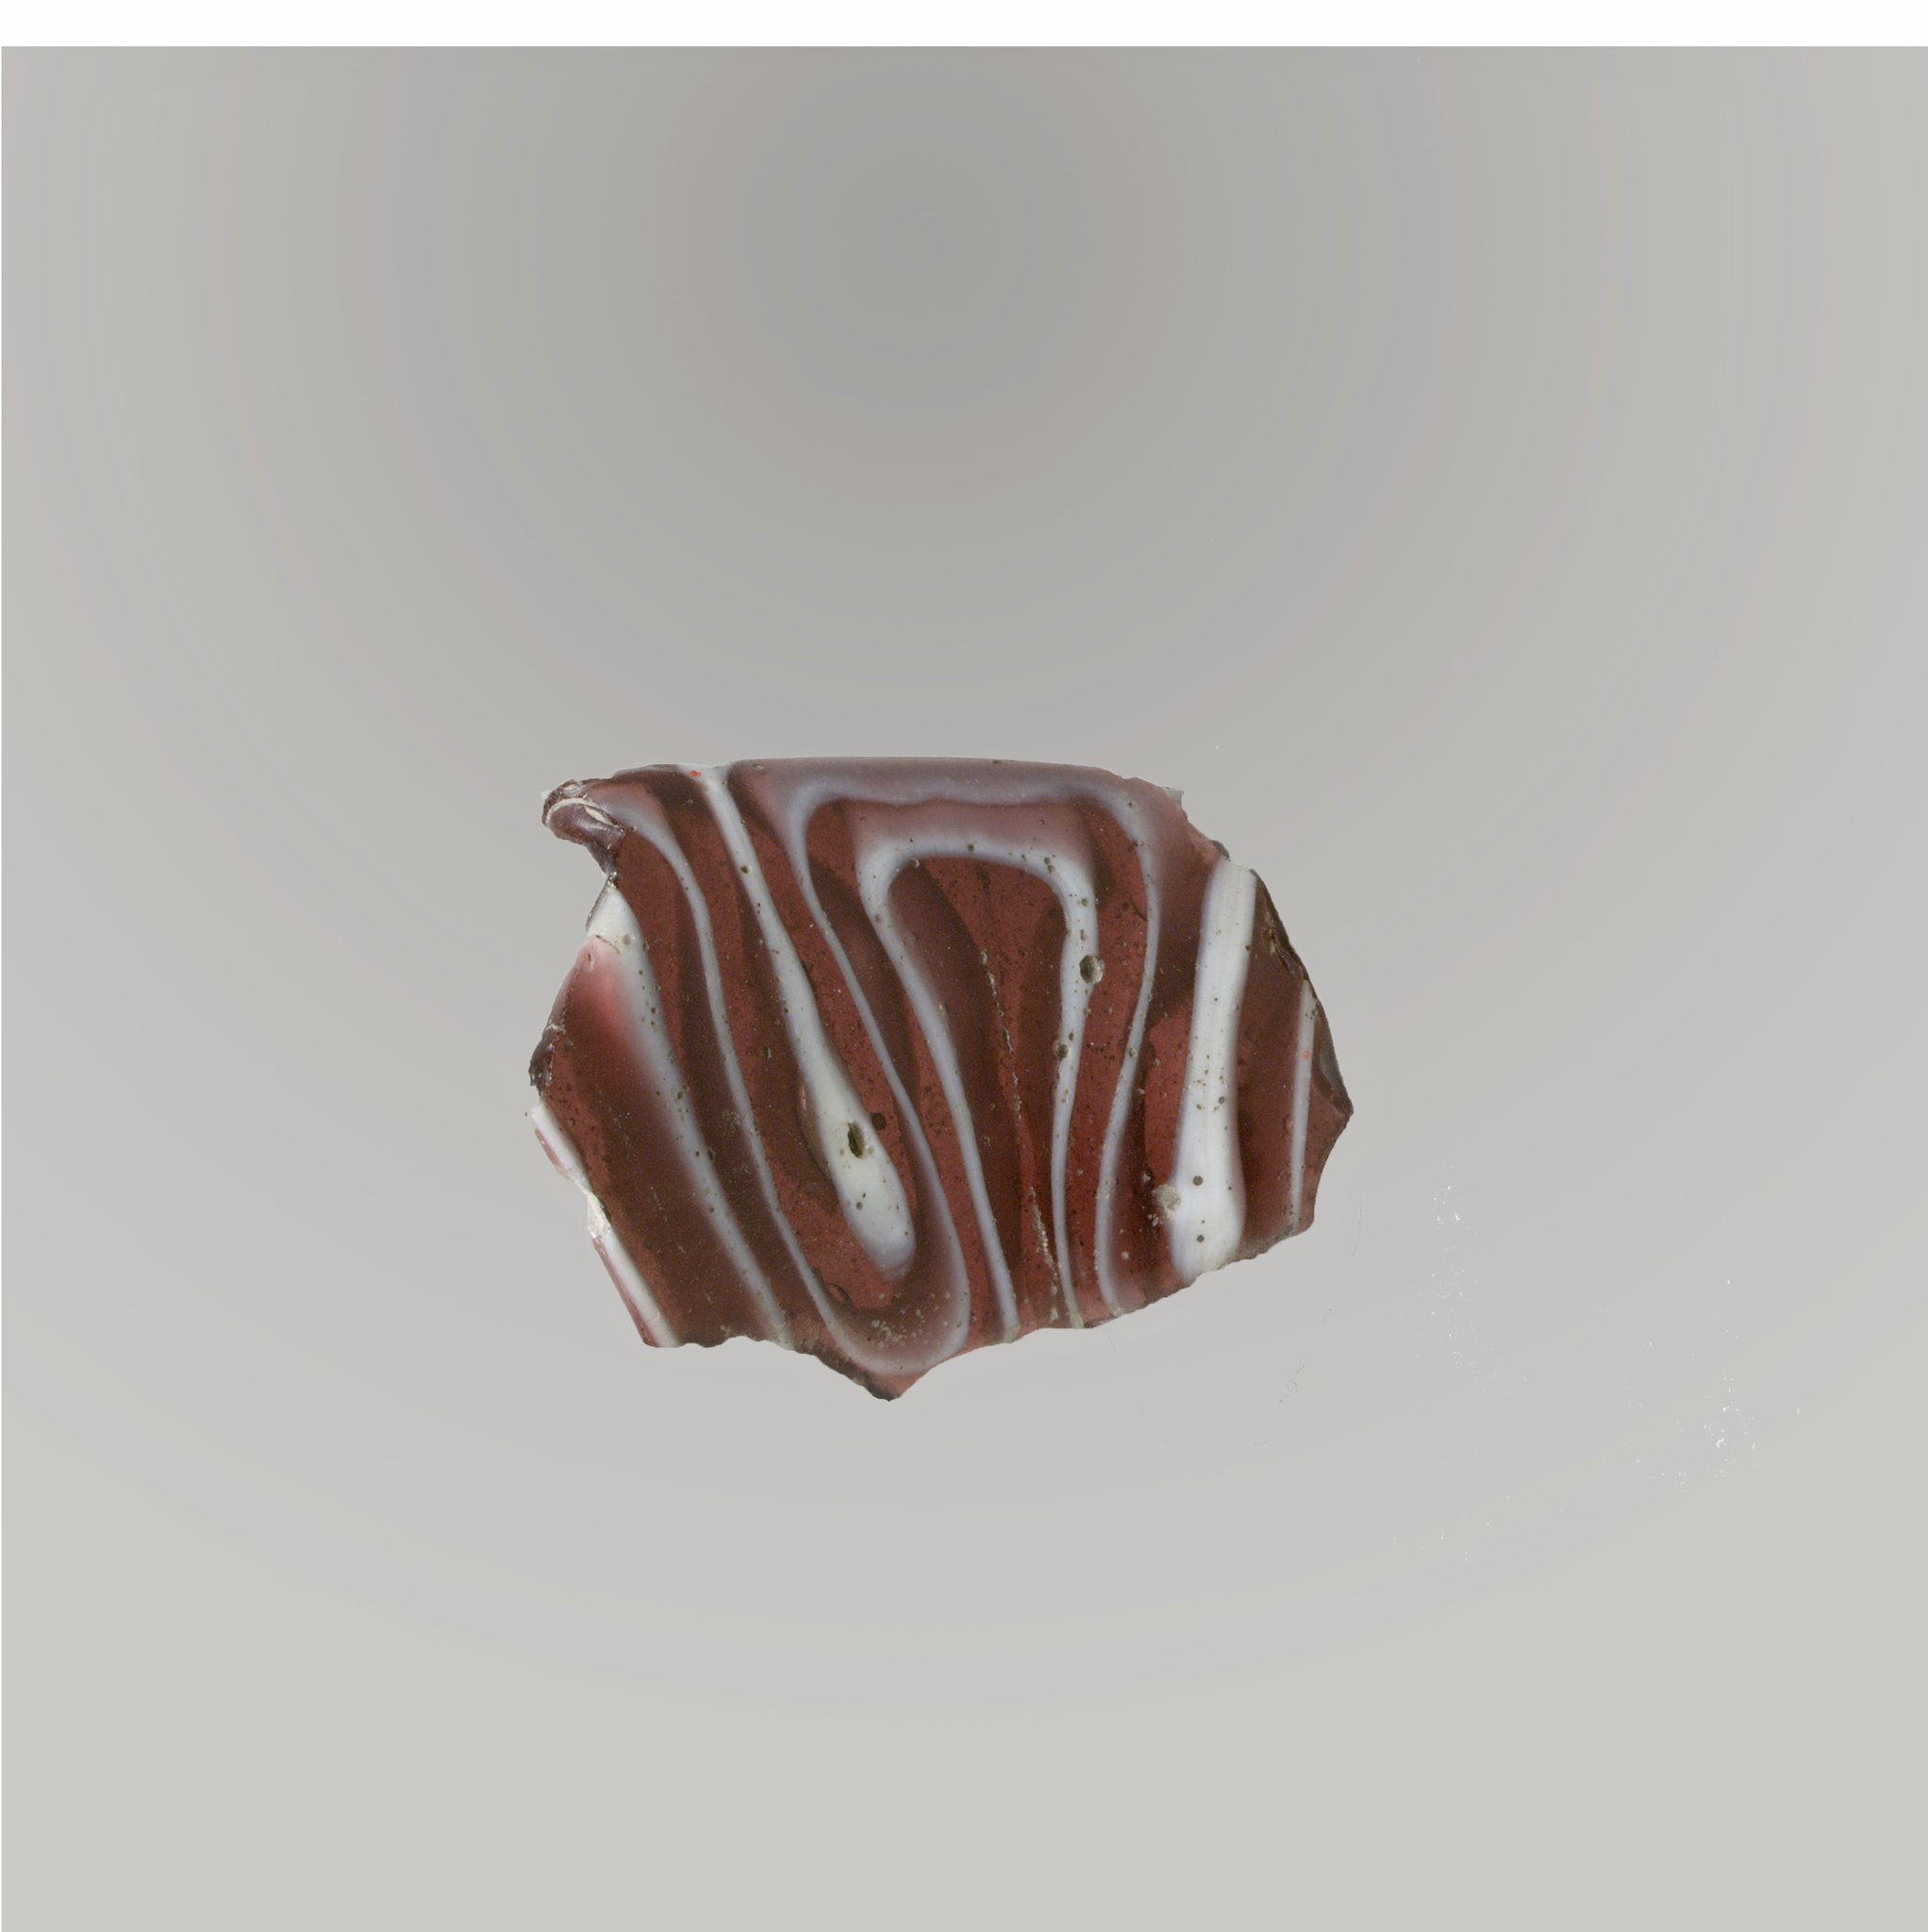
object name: fragment, mosaic bowl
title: Glass mosaic bowl fragment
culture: roman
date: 34 BCE-33 CE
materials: glass